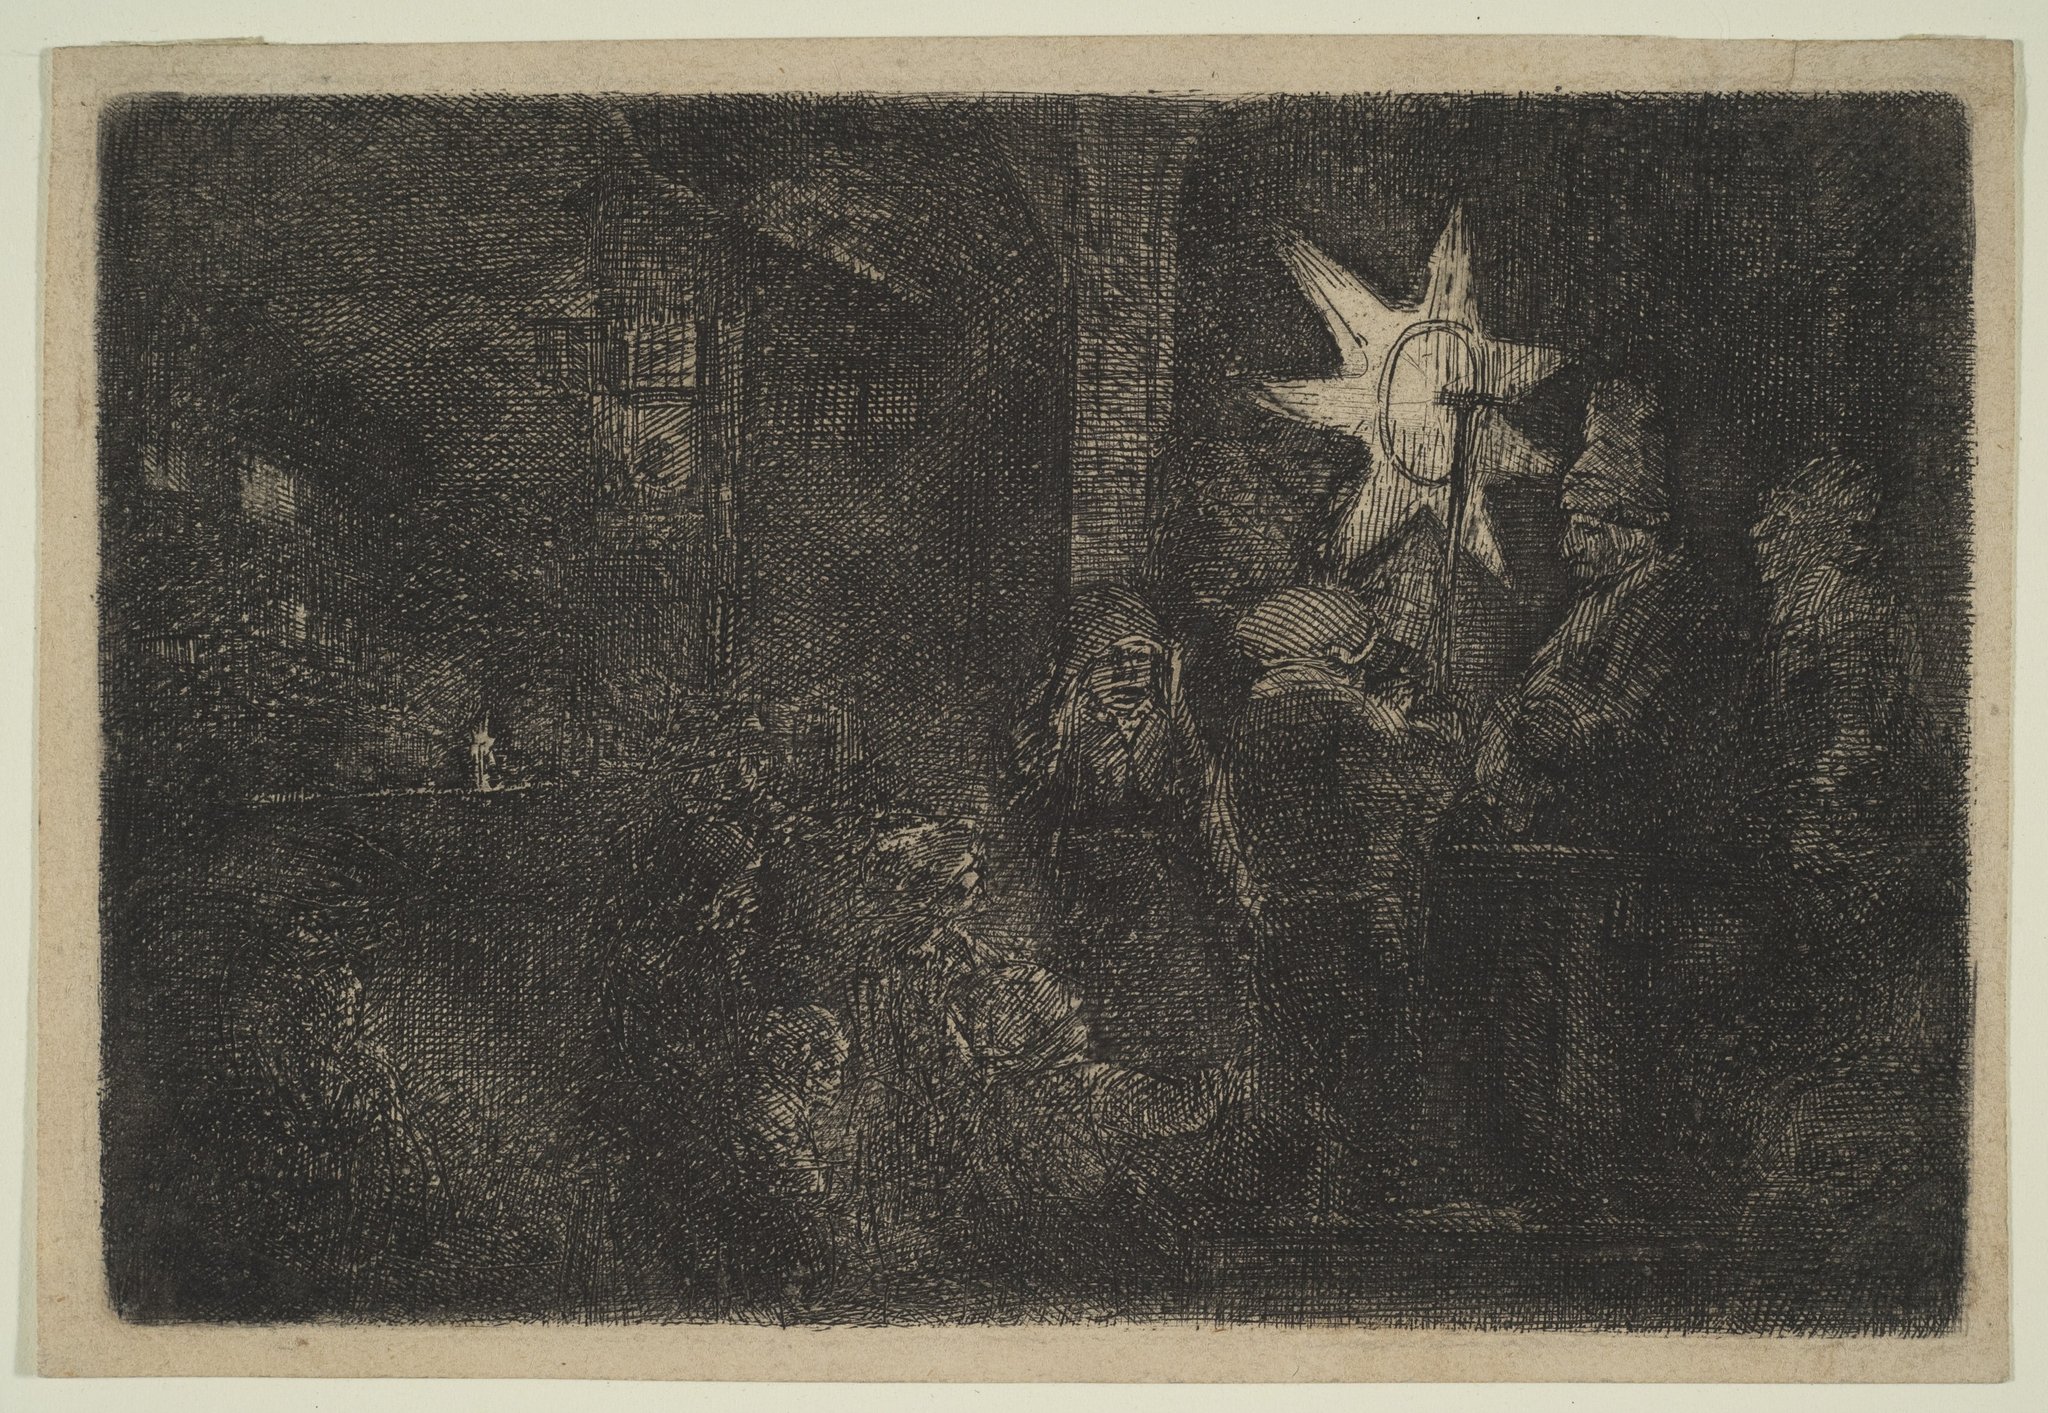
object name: print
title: The Star of Kings: A Night Piece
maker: rembrandt van rijn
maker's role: artist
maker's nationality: dutch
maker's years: 1606-1669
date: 1651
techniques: drypoint, etching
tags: men,women,stars,night